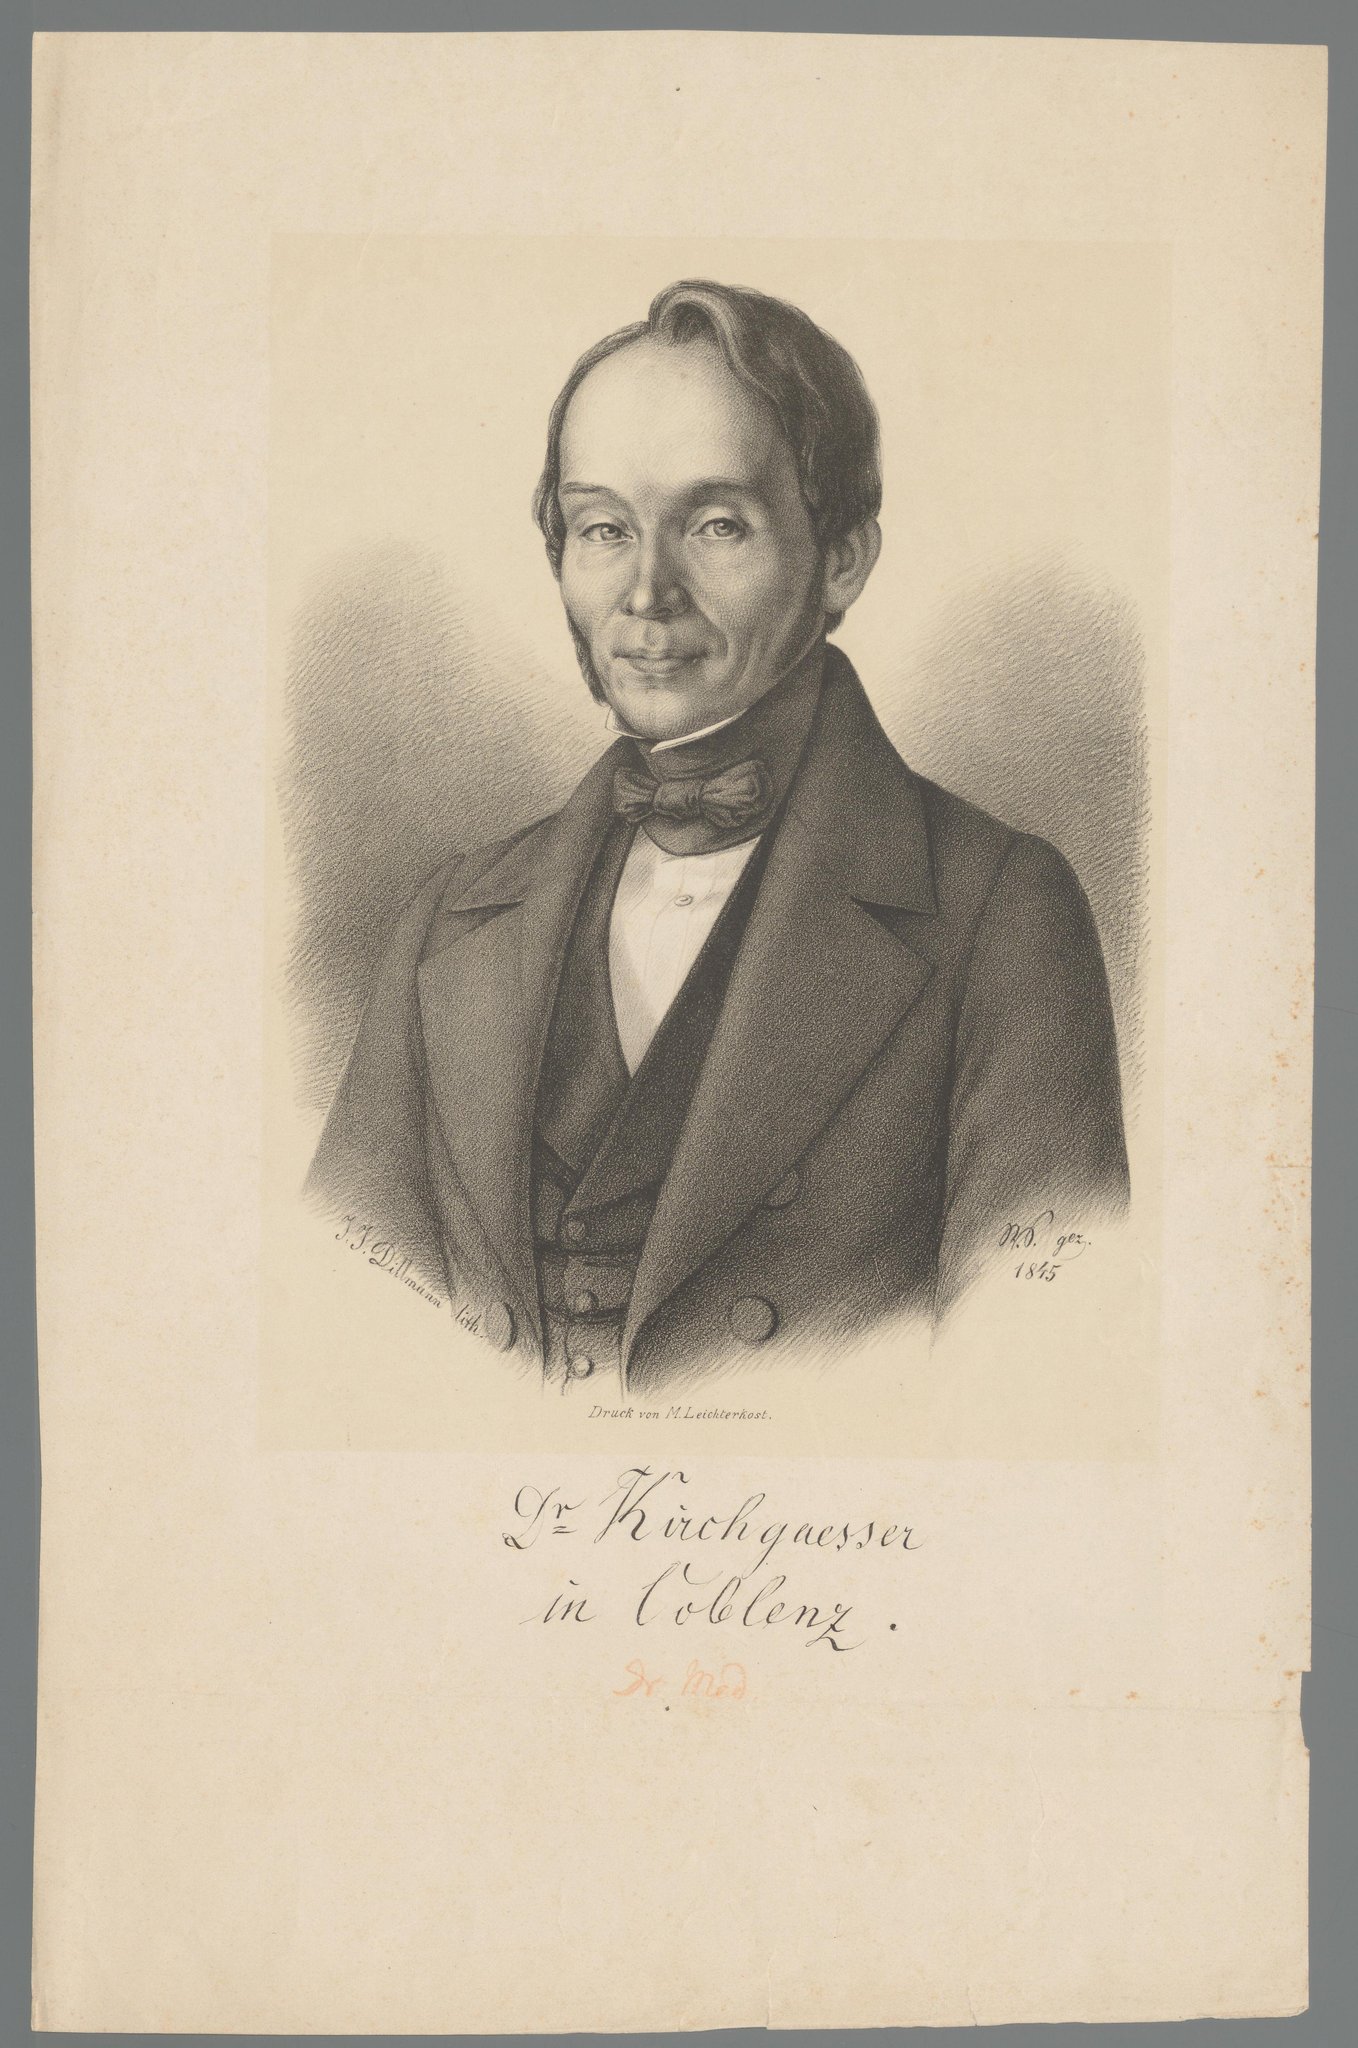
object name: print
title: Portret van Kirchgaesser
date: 1845-1850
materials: paper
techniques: tone lithography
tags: adult man, historical persons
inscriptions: collector's mark: Lugt 2228